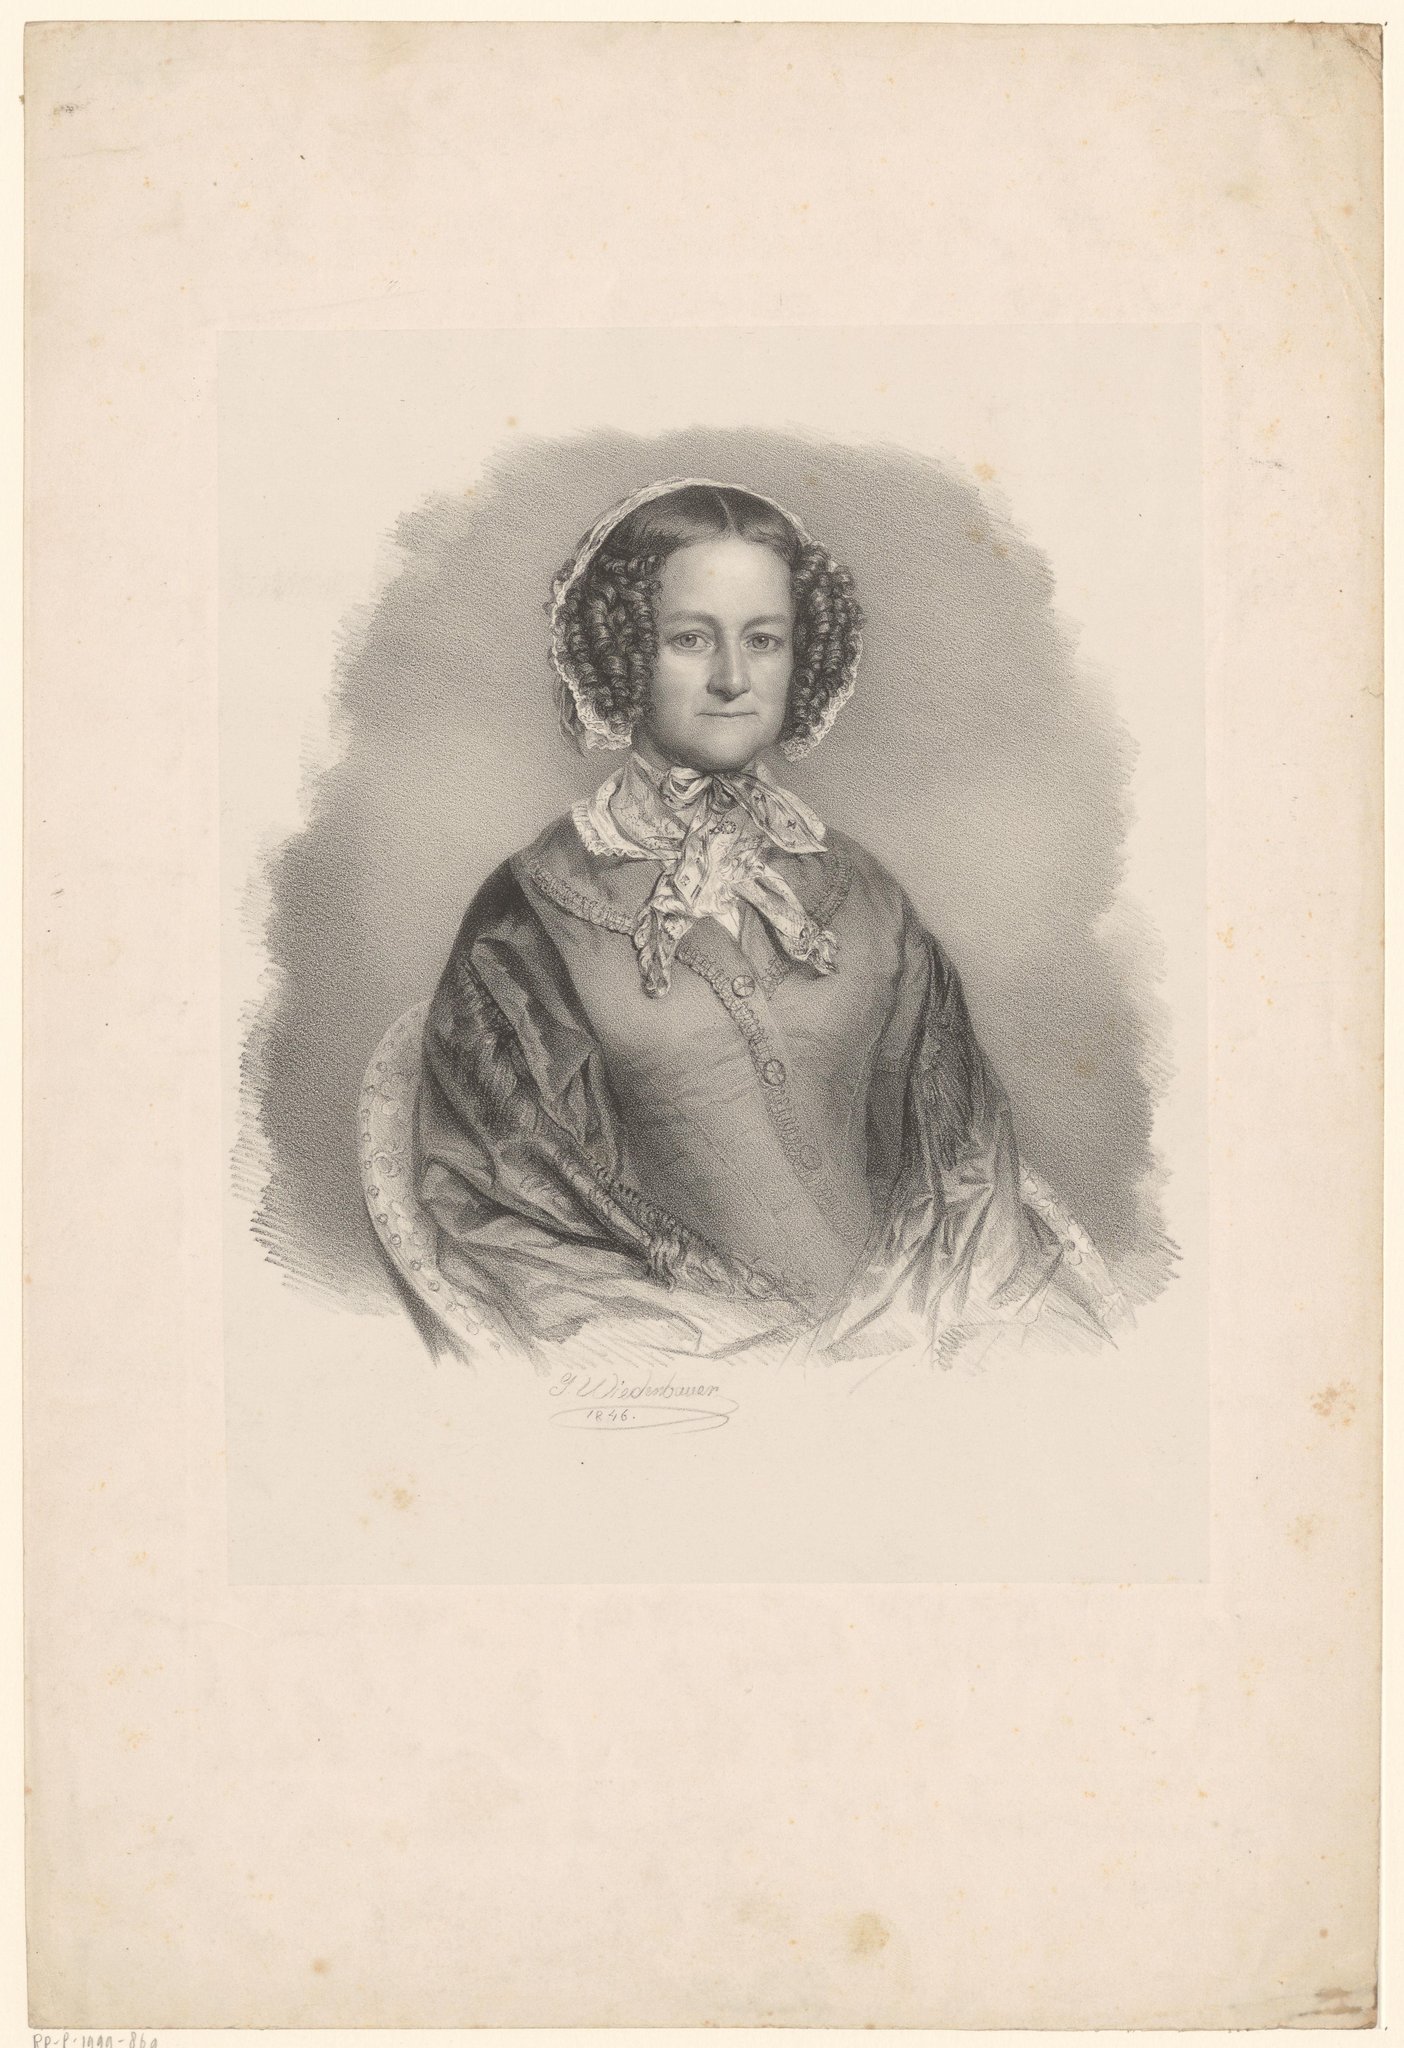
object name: print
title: Portret van een onbekende vrouw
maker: wiedenbauer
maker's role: print maker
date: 1846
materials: paper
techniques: lithograph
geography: germany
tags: adult woman, historical persons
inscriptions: collector's mark: Lugt 2228, collector's mark: Lugt 2760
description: Vrouw zittend in een leunstoel, ten halve lijve, naar rechts. Muts op het hoofd.